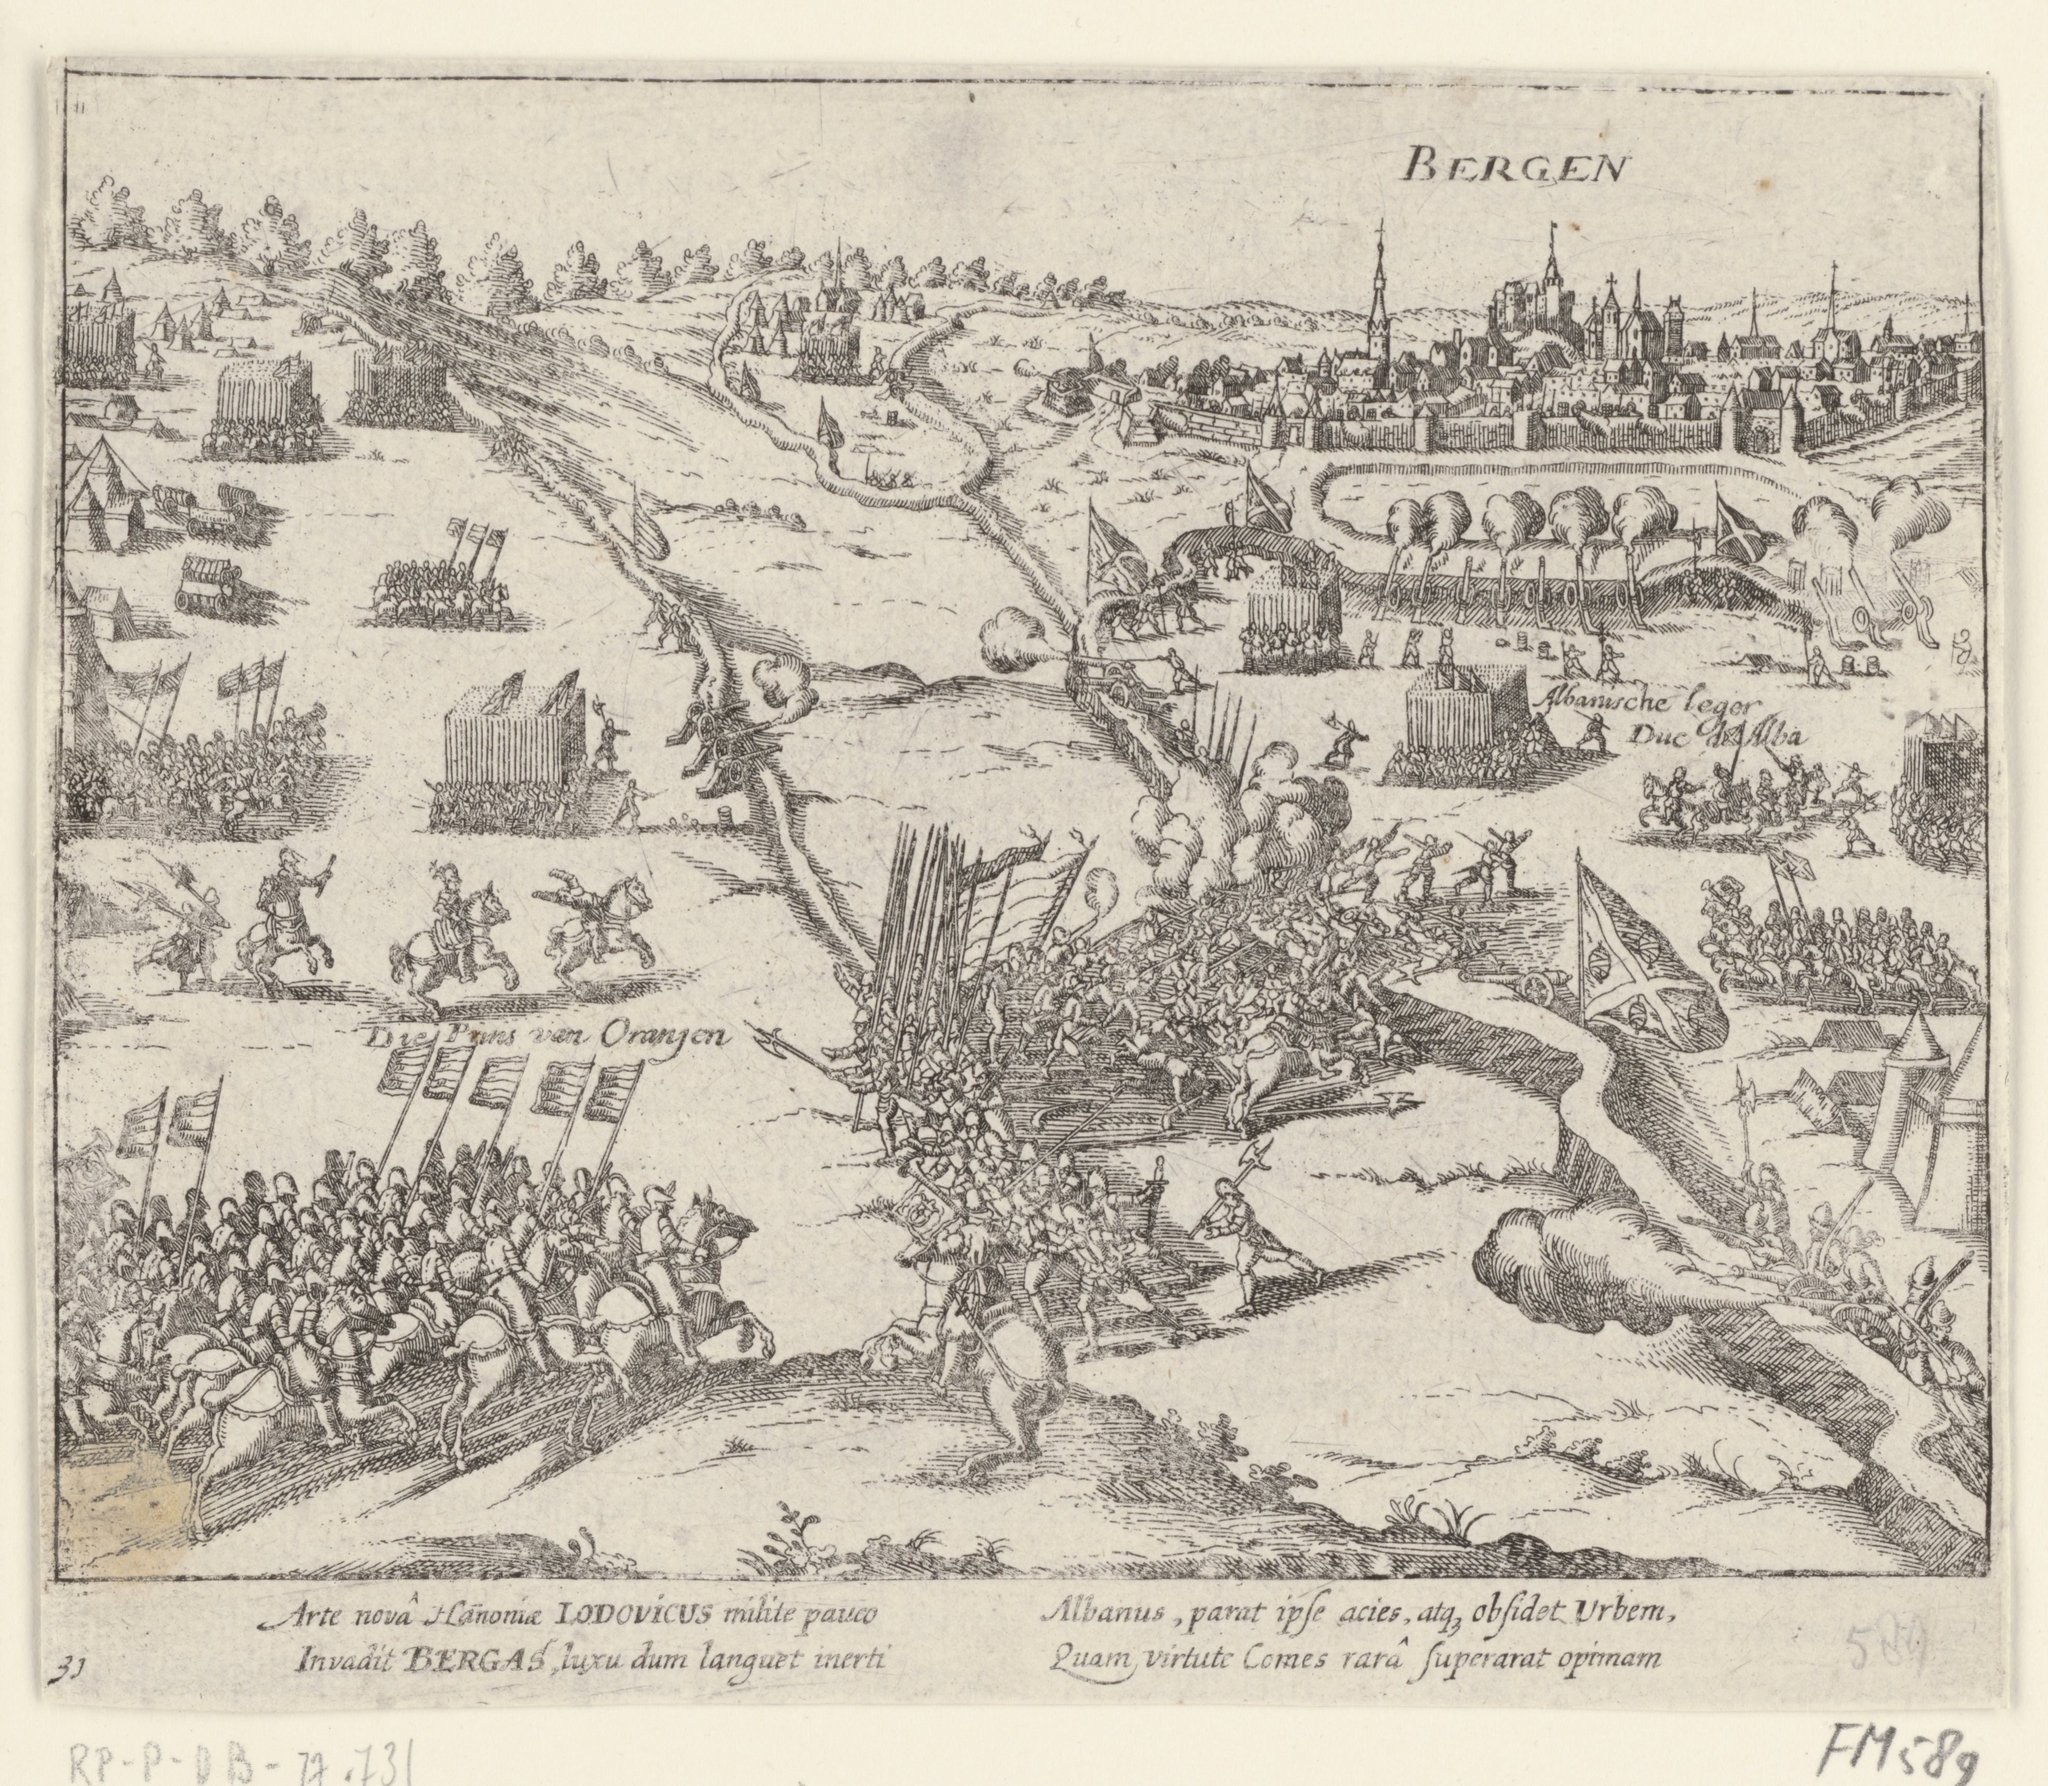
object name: history print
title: Alva belegert Bergen in Henegouwen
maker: Anonymous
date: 1613-1615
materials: paper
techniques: etching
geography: germany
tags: delft, william i (prince of orange), fernando álvarez de toledo (3rd duke of alba), siege, position war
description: Bergen in Henegouwen, door graaf Lodewijk van Nassau met list gewonnen, belegerd door Alva, 18 augustus 1572. Van links komt het leger van Willem van Oranje in een poging om de stad te ontzetten. Met onderschrift van 4 regels in het Latijn. Genummerd: 31. Bedrukt op achterzijde met tekst in het Latijn.